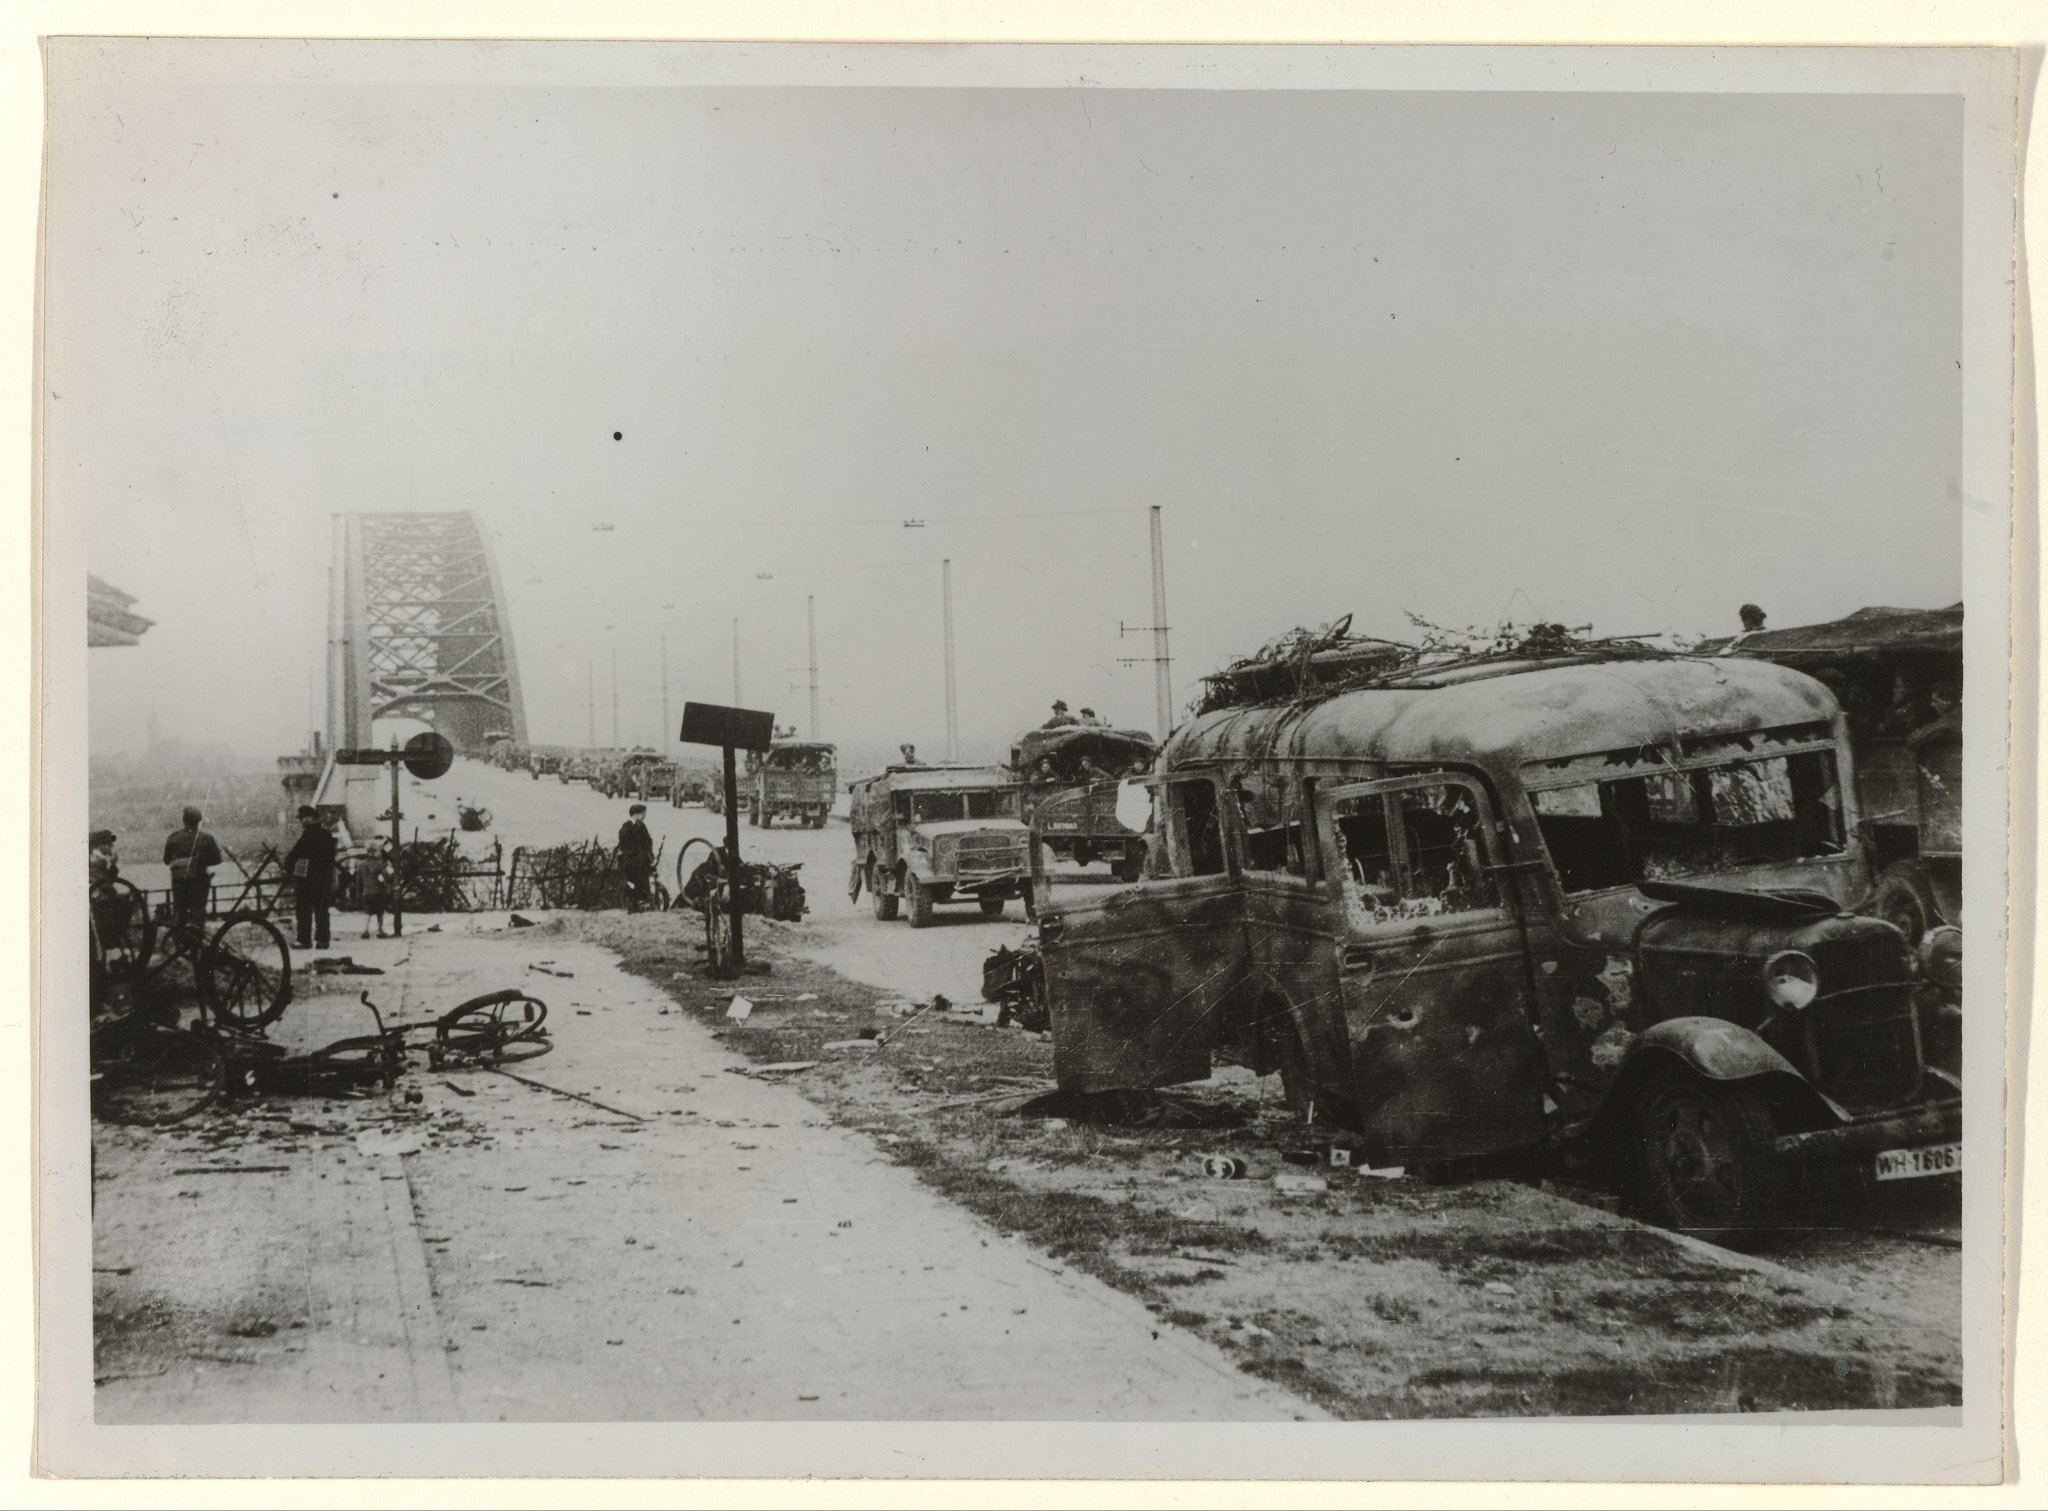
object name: documentary photograph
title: Britse troepen passeren de brug bij Nijmegen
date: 1909-1944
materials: photographic support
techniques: photography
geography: nijmegen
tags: nijmegen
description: Britse troepen passeren de brug bij Nijmegen nadat parachutisten de brug heroverd hadden op de Duitse troepen. Op de voorgrond het wrak van een Duits voertuig. Tijdens de slag om Arnhem (Operatie Market Garden) werd er zwaar gevochten om de bruggen in de regio.